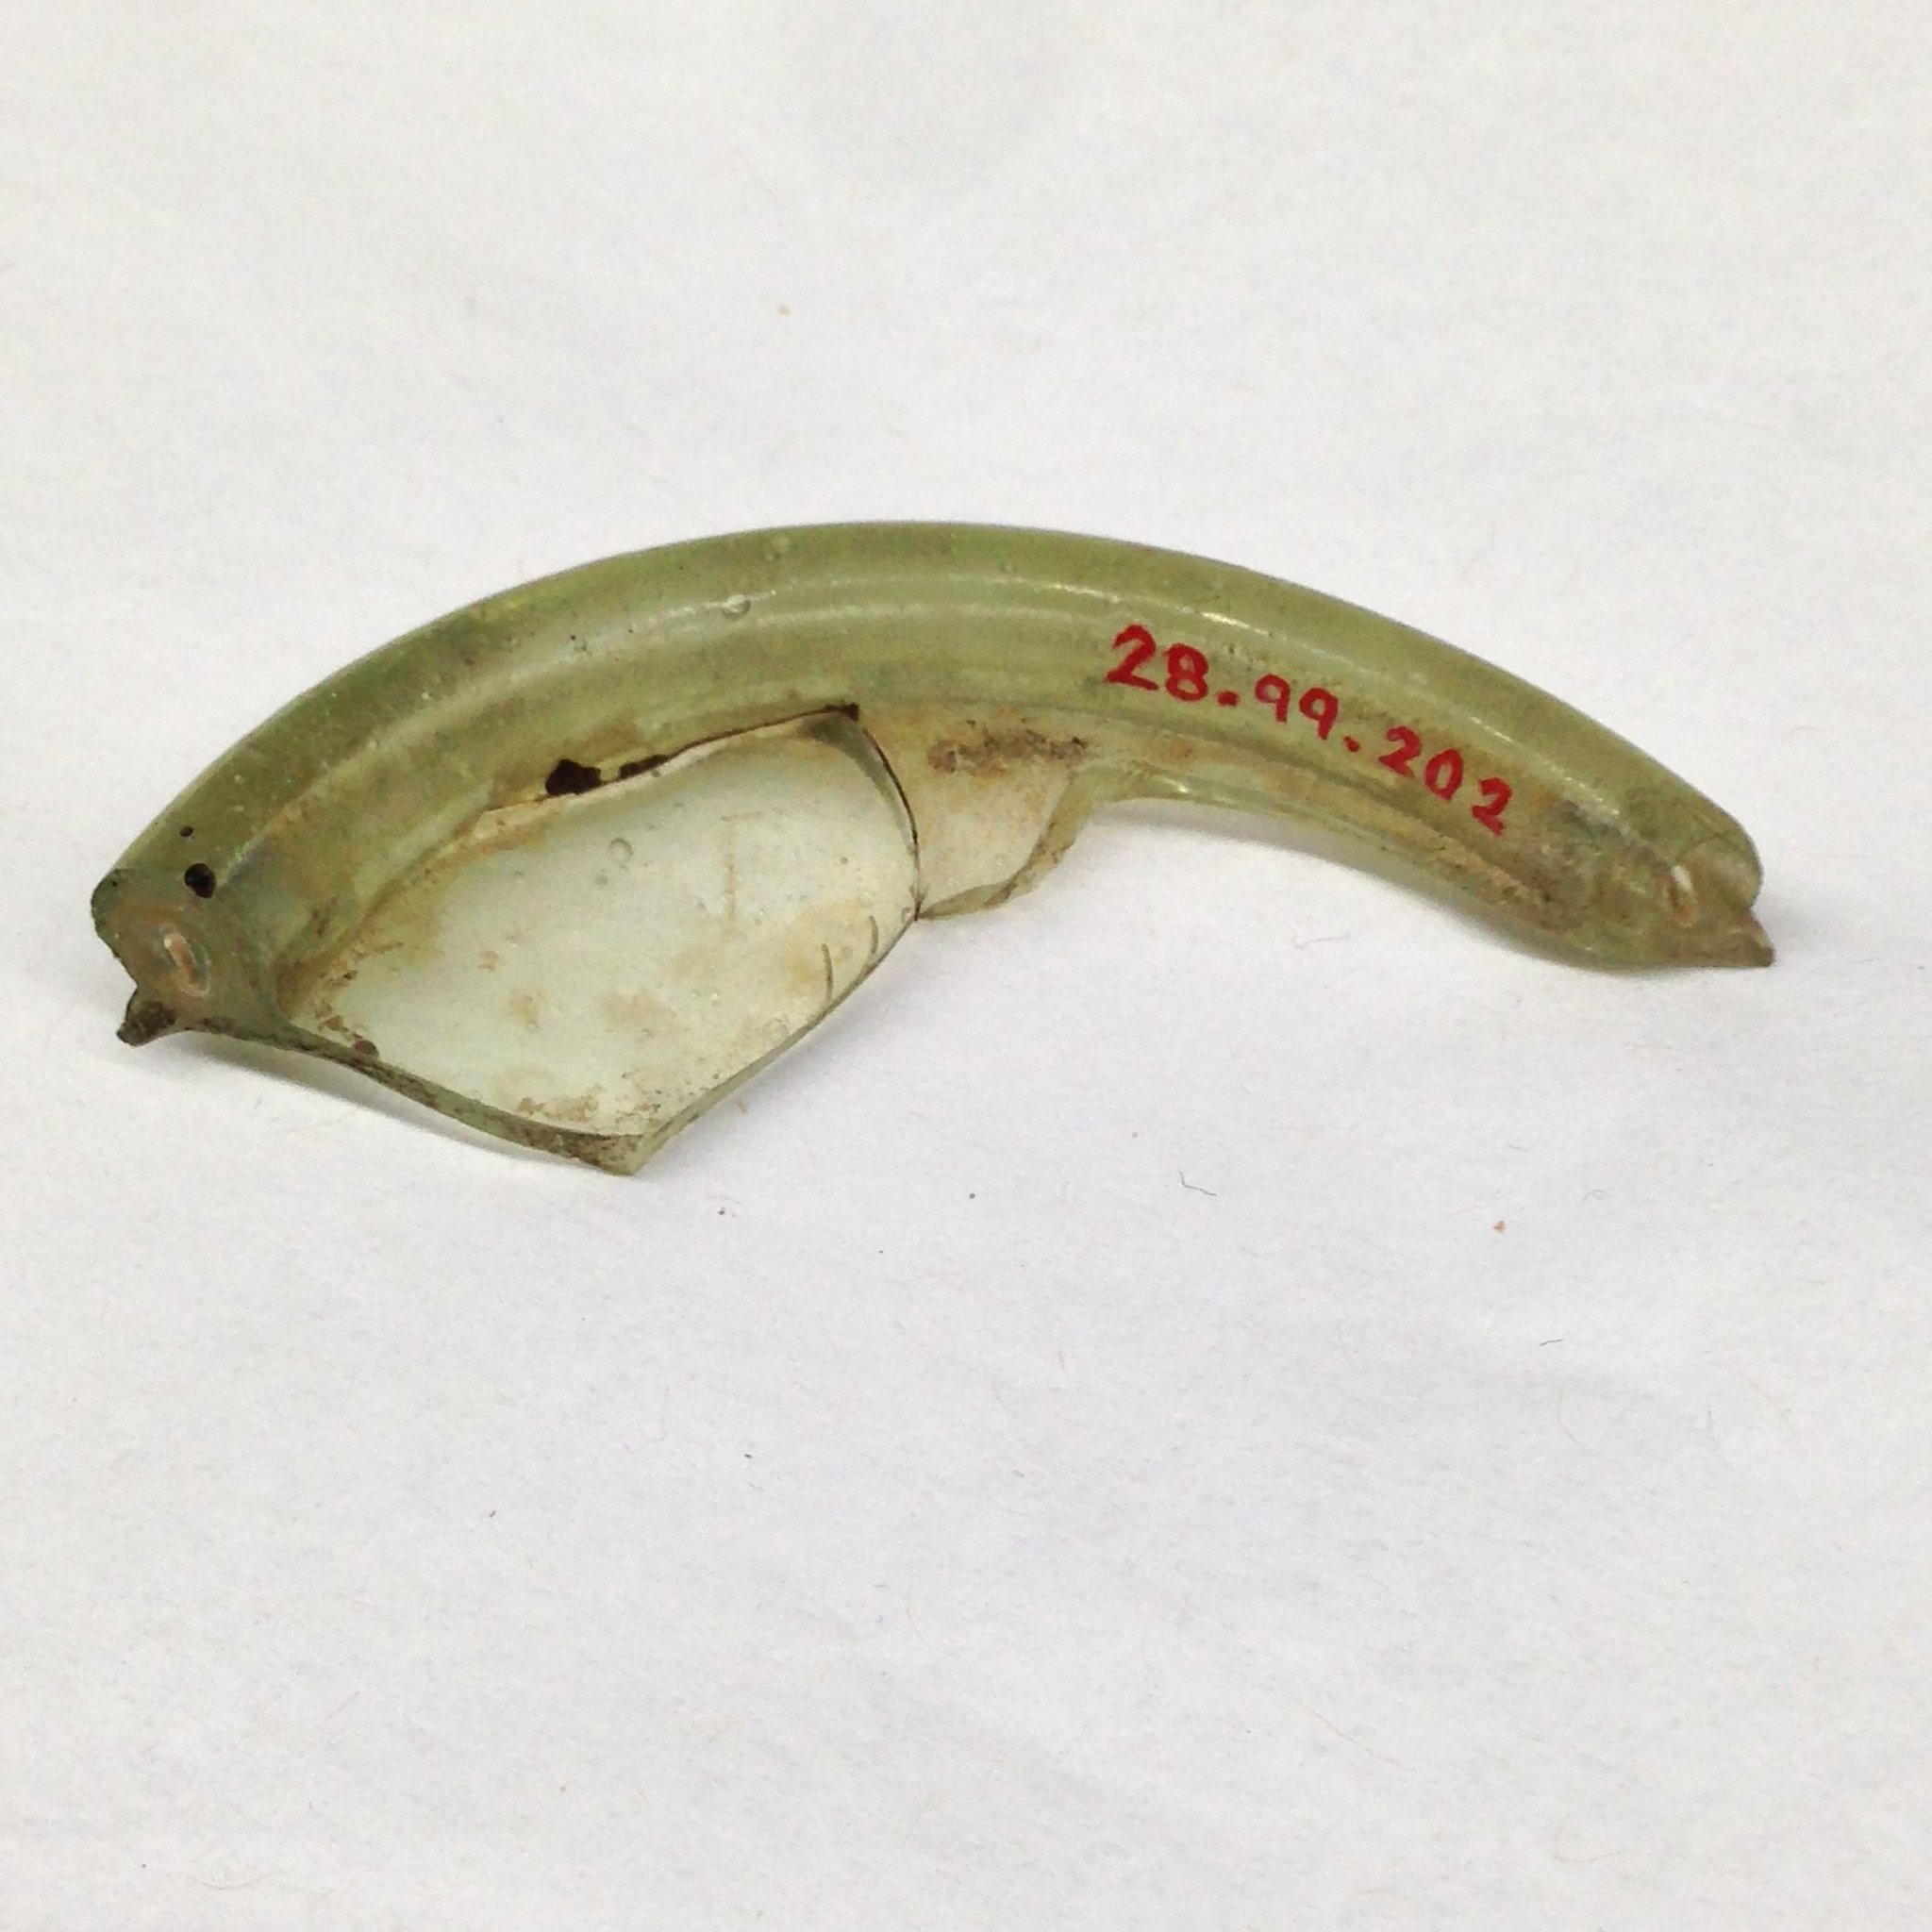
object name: fragment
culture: european or middle eastern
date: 1150-1250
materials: ceramic, glass